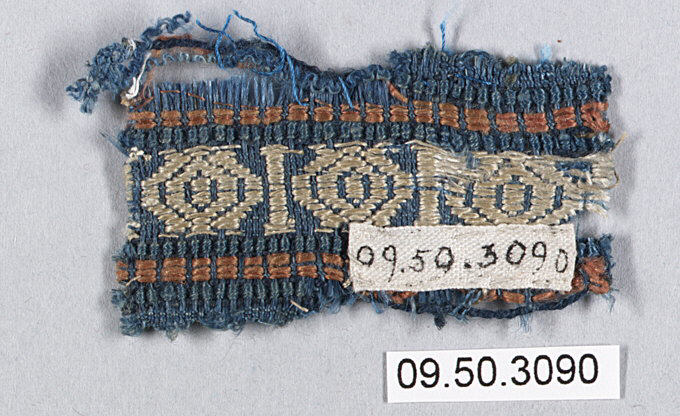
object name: gimp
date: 1701-1900